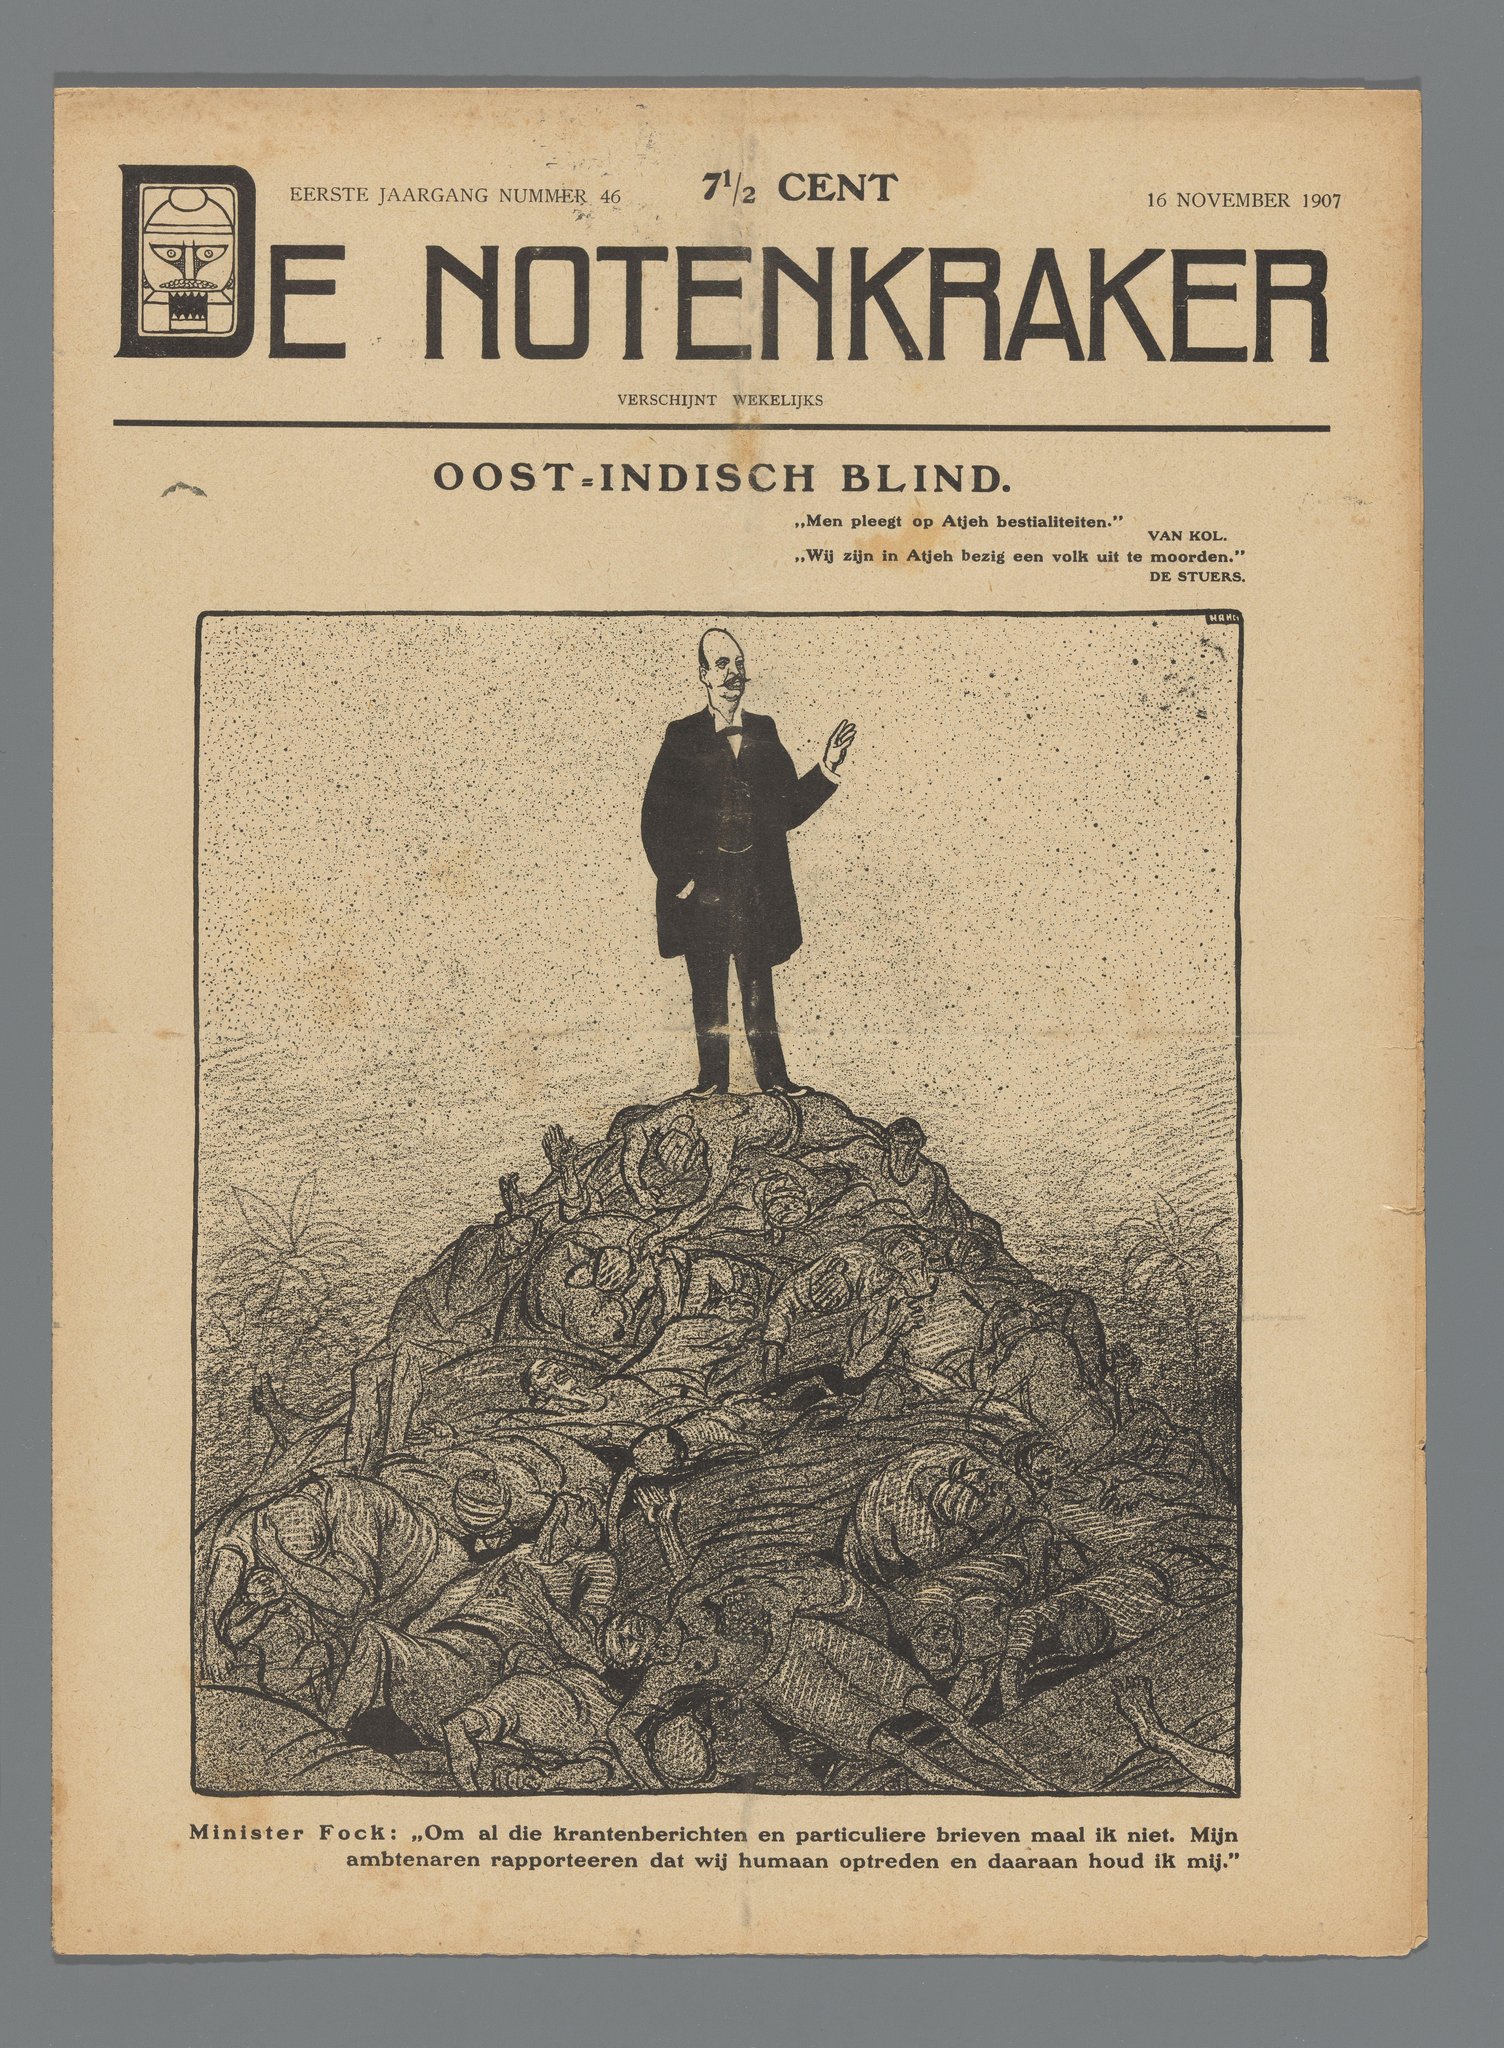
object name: magazine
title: De Notenkraker, 16 november 1907 / Oost-Indisch blind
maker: albert hahn (i)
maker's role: draughtsman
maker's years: 1877-1918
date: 1907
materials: paper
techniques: lithograph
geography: netherlands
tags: colonial government, massacre ~ war, political caricatures and satires, netherlands, dutch east indies, the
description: Aflevering van het satirische tijdschrift De Notenkraker van 16 november 1907, eerste jaargang, nummer 46. Omslag met illustratie van minister van koloniën Dirk Fock staande op een berg van lichamen van vermoorde inwoners van Atjeh, tijdens de Atjehoorlog. Onderdeel van een volledige eerste jaargang (1907). Elk nummer bevat 8 bladzijden, deels nog niet losgesneden, met op de voorzijde steeds een spotprent van Albert Hahn, op de overige pagina's prenten van Hahn steeds tussen de tekst. In de letter 'D' van de titel is een kop van een zgn. notenkraker afgebeeld.